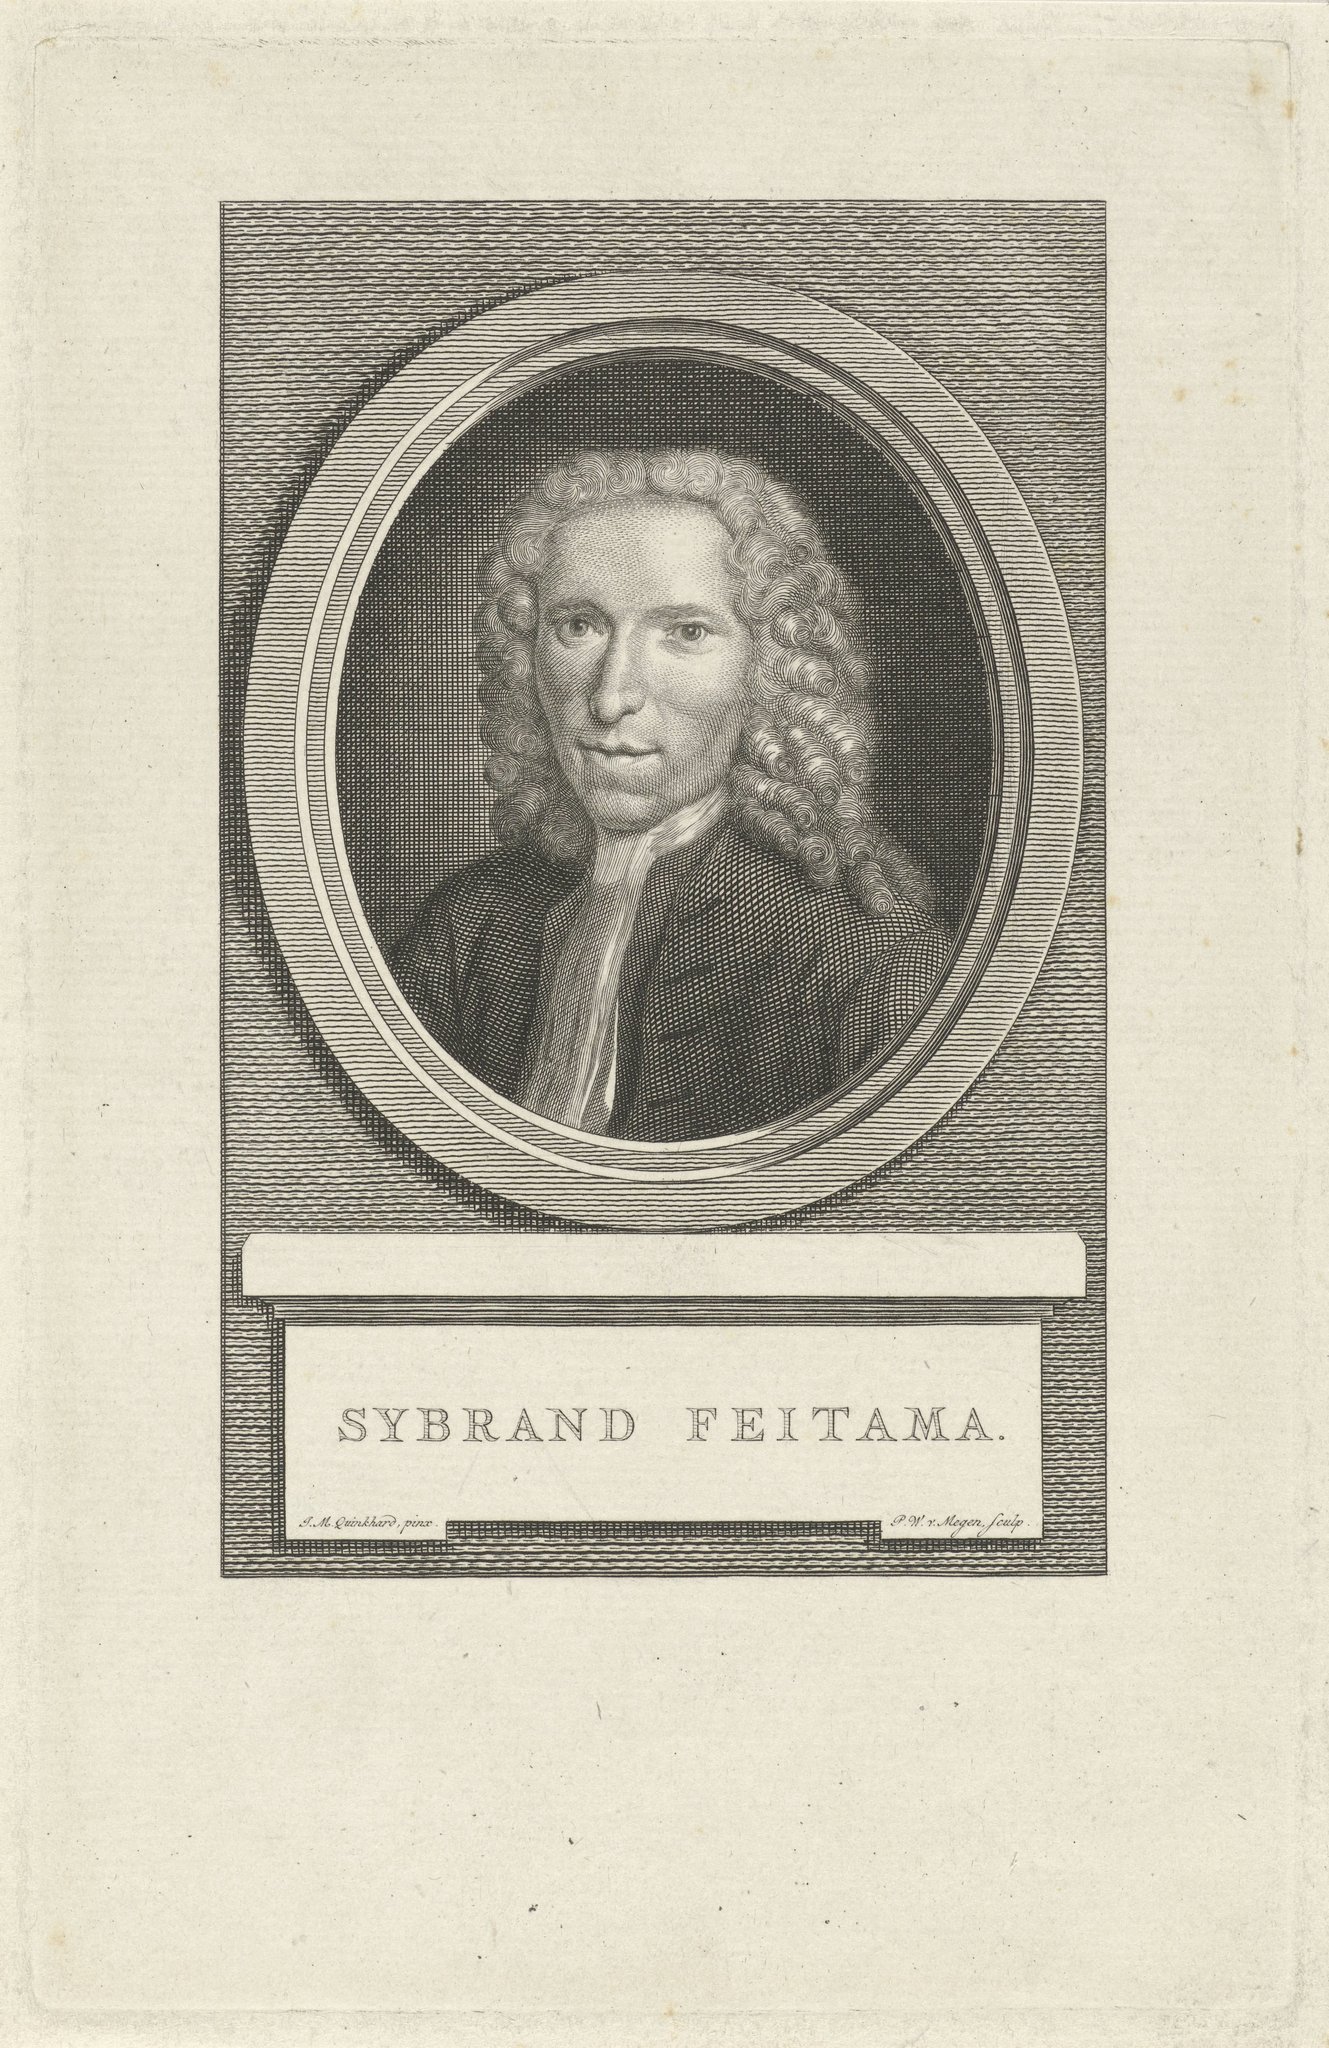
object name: print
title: Portret van Sybrand Feitama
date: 1760-1785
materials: paper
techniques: engraving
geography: the hague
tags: amsterdam, draughtsman, sybrand feitama (ii)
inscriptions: collector's mark: Lugt 2228, inscription: ‘Pecker.’